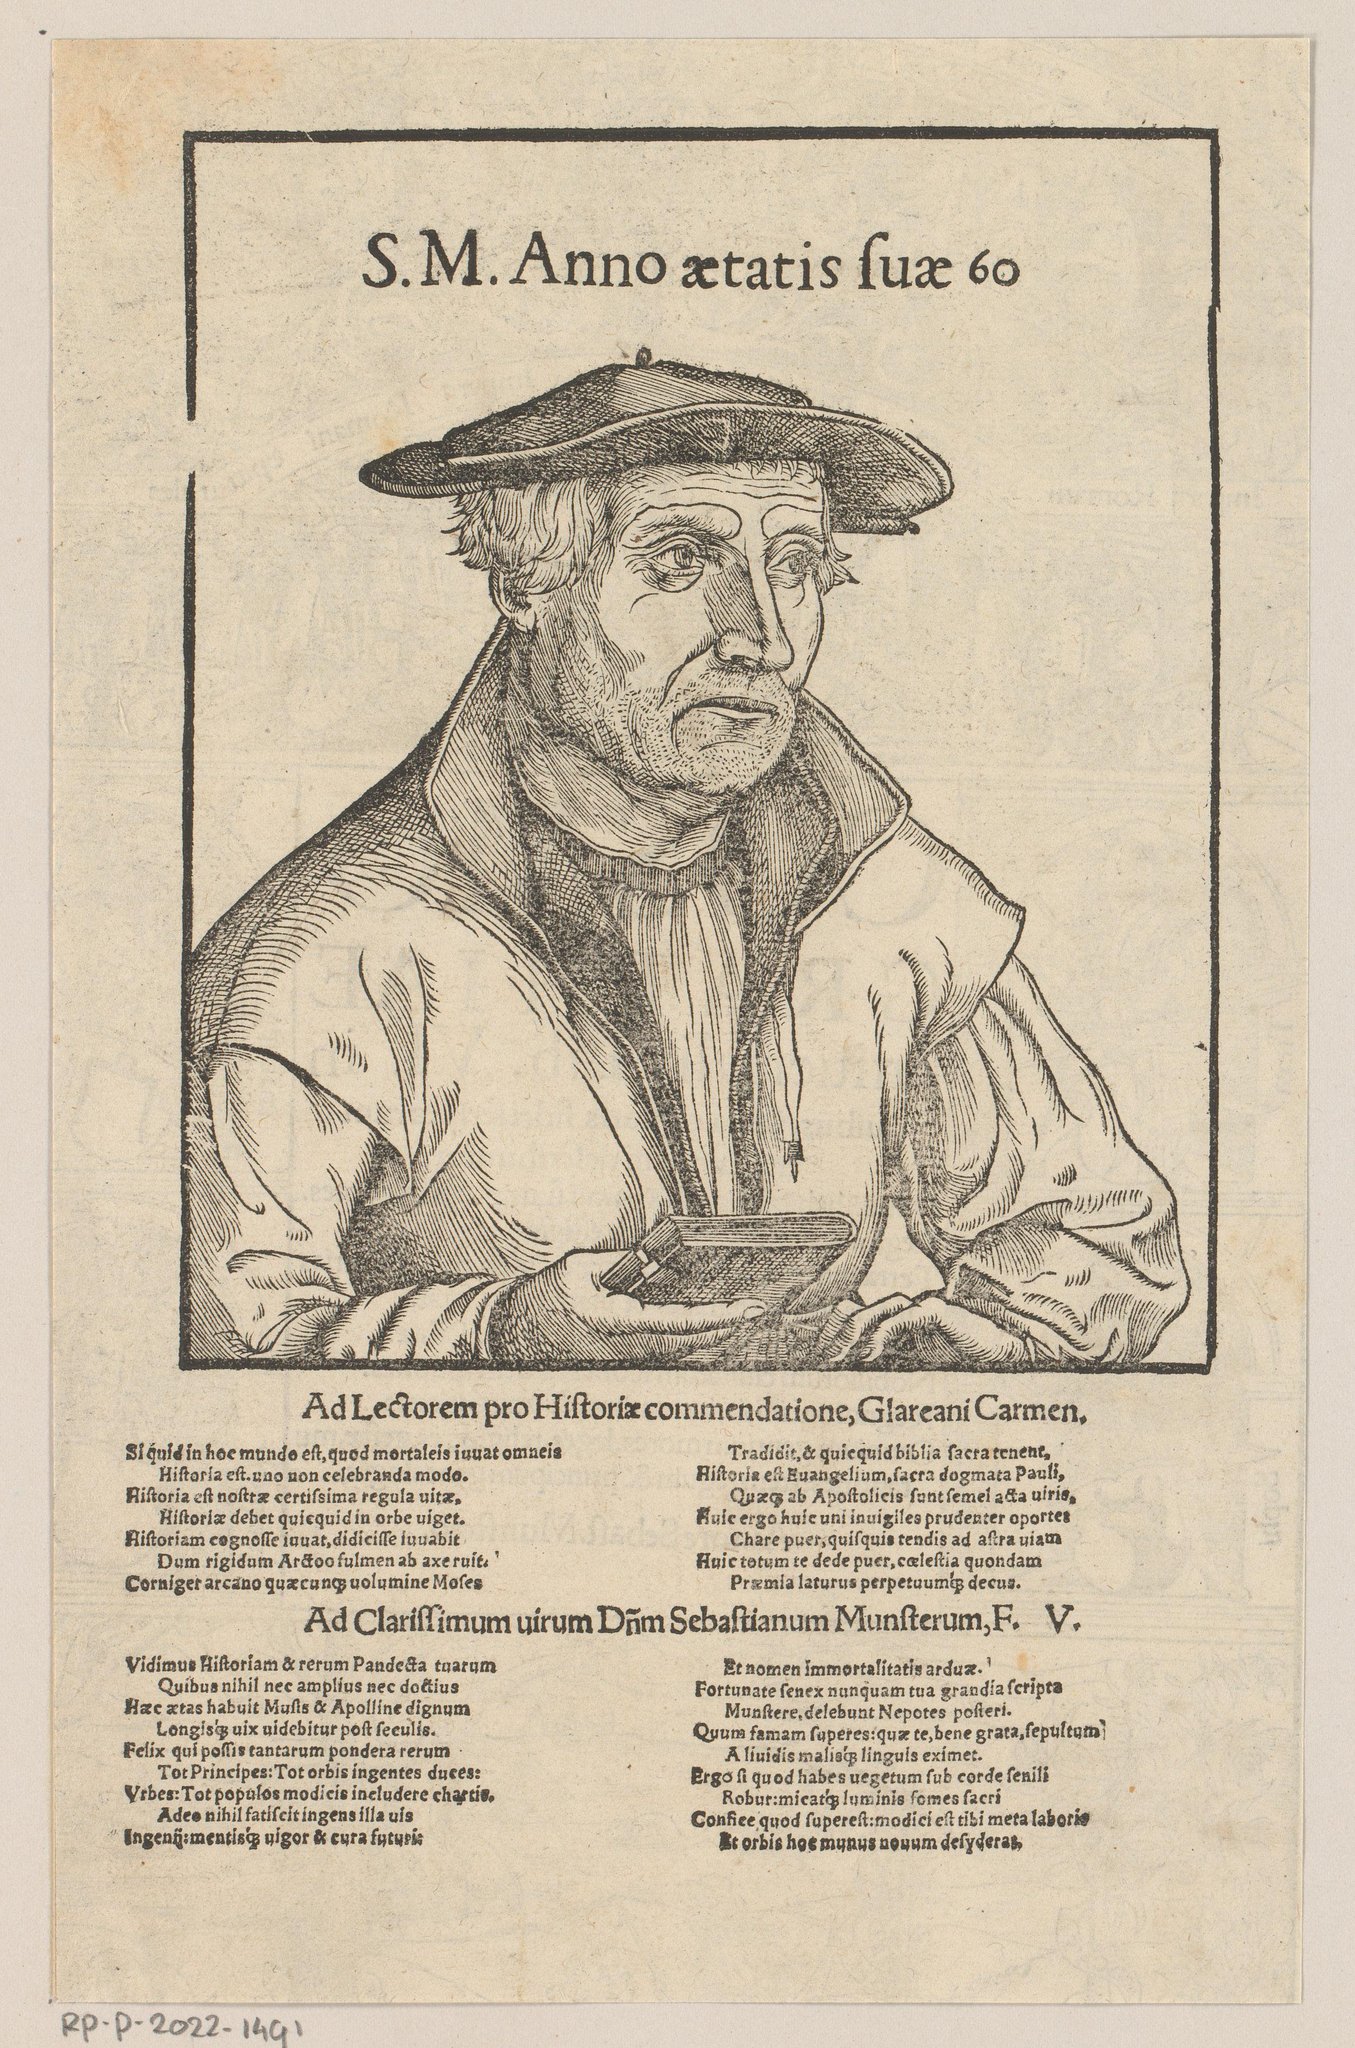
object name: print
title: Portret van Sebastian Münster op 60-jarige leeftijd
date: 1554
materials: paper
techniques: letterpress printing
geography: basel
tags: scholar, philosopher, historical persons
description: Prent uit: Münster, Sebastian. Cosmographiae uniuersalis (...). Bazel: Heinrich Petri, 1554, dl. 6.